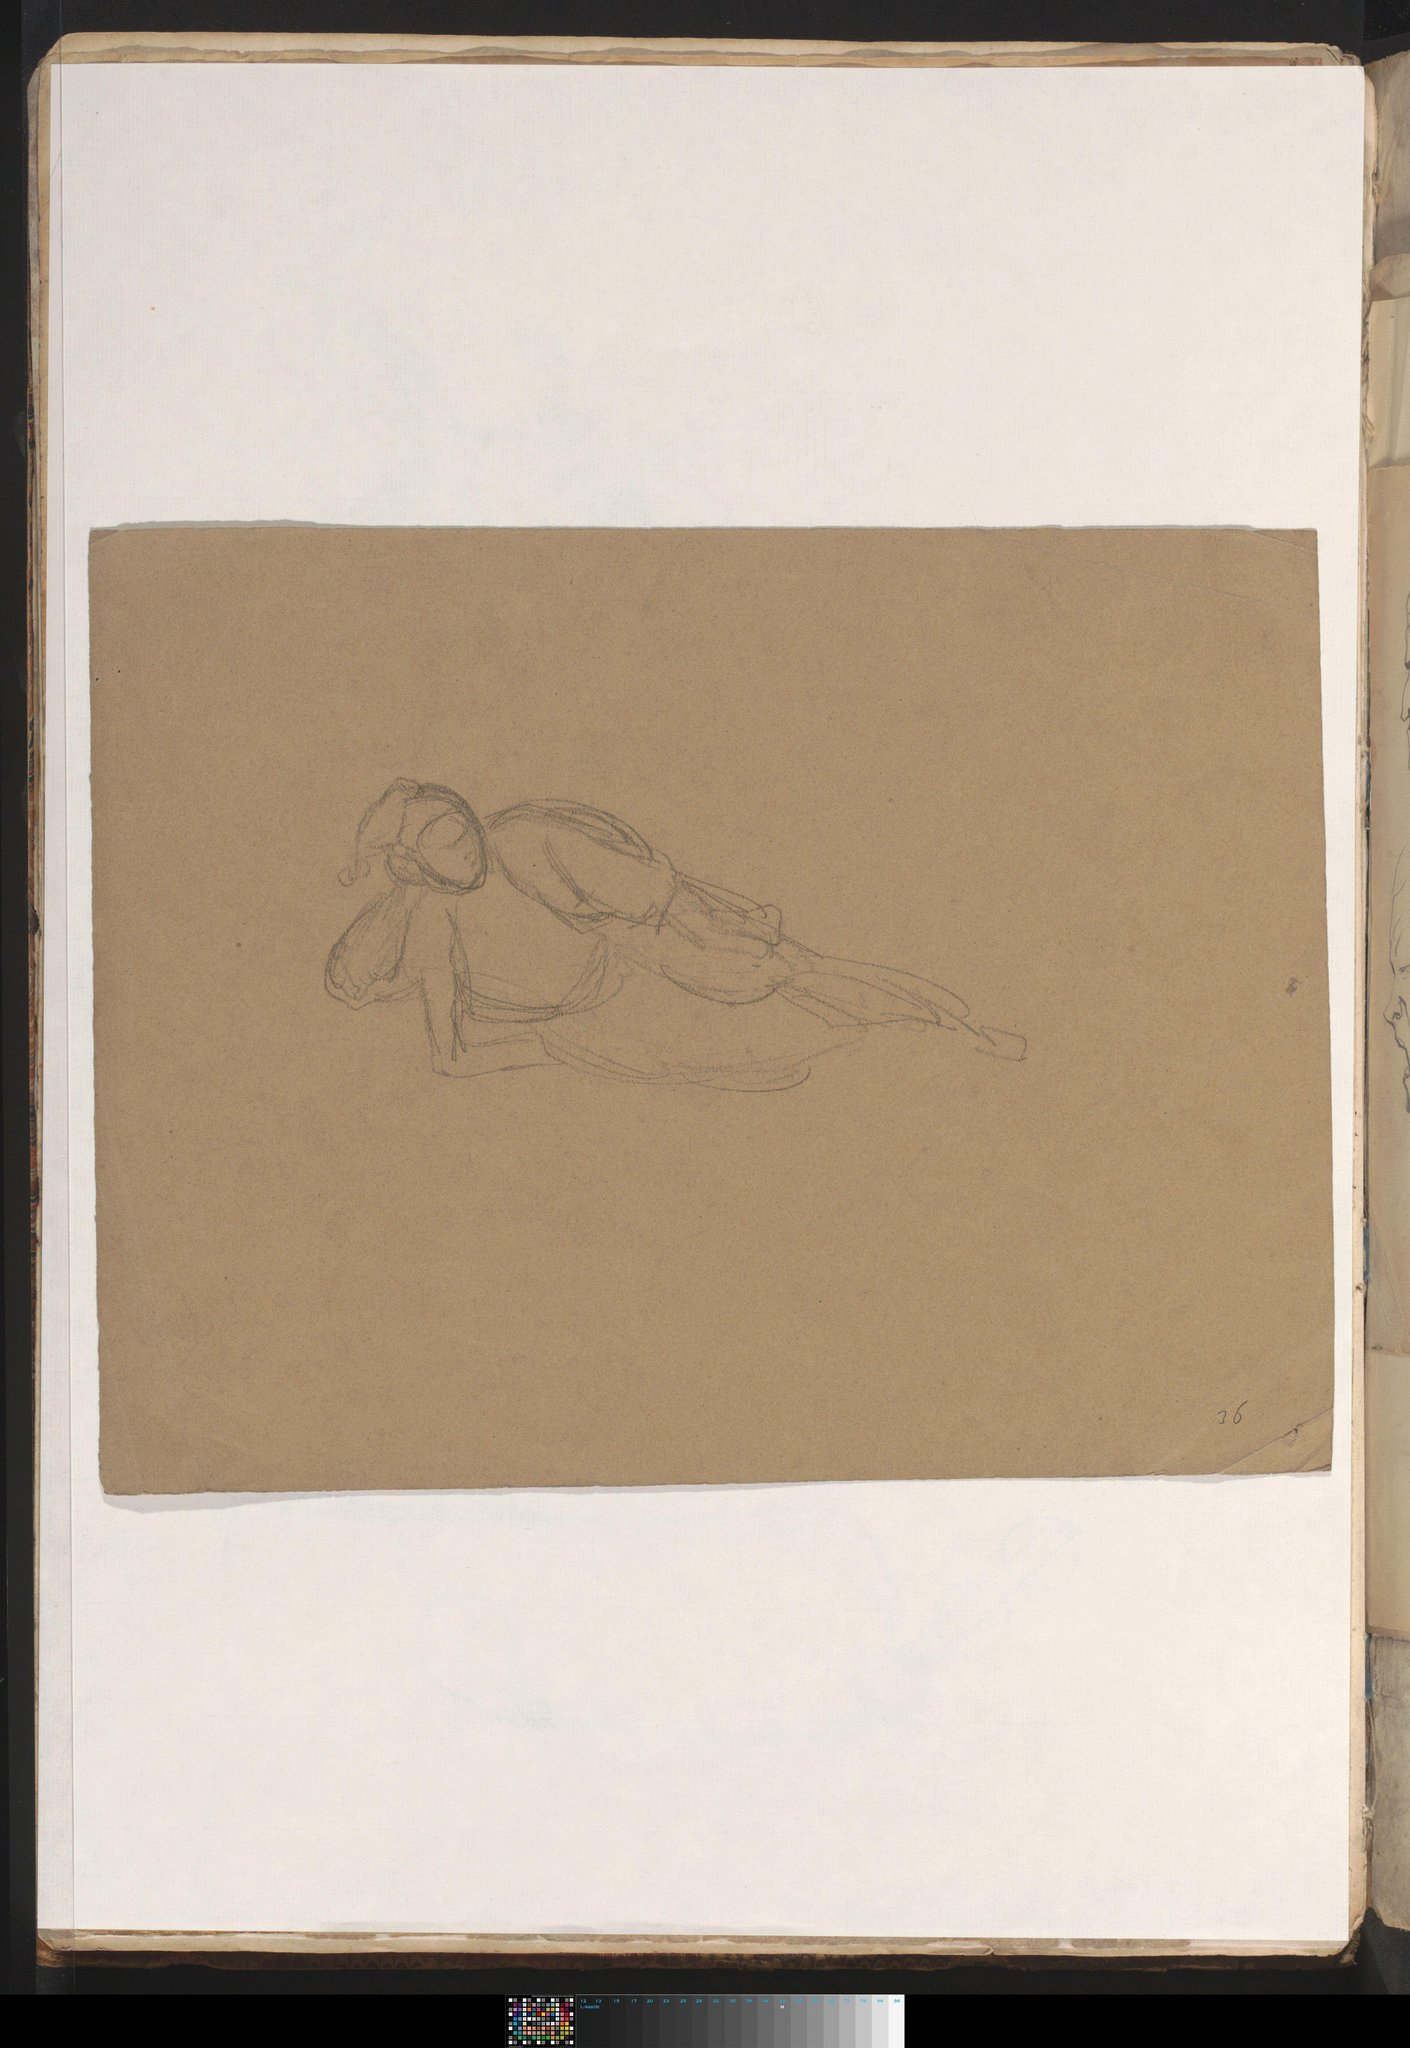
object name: sketchbook leaf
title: Liggende man met een slaapmuts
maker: johannes huybertus van hove bzn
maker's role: print maker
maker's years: 1827-1881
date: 1837-1881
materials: paper, pencil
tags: nightwear: night-cap (+ men's clothes), lying on one side, with uplifted upper part of the body and leaning on the arm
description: De man ligt op zijn zij en ondersteunt zijn hoofd met zijn linkerhand. Blad 36 verso, los blad in een schetsboek met 33 bladen en 10 losse tekeningen.